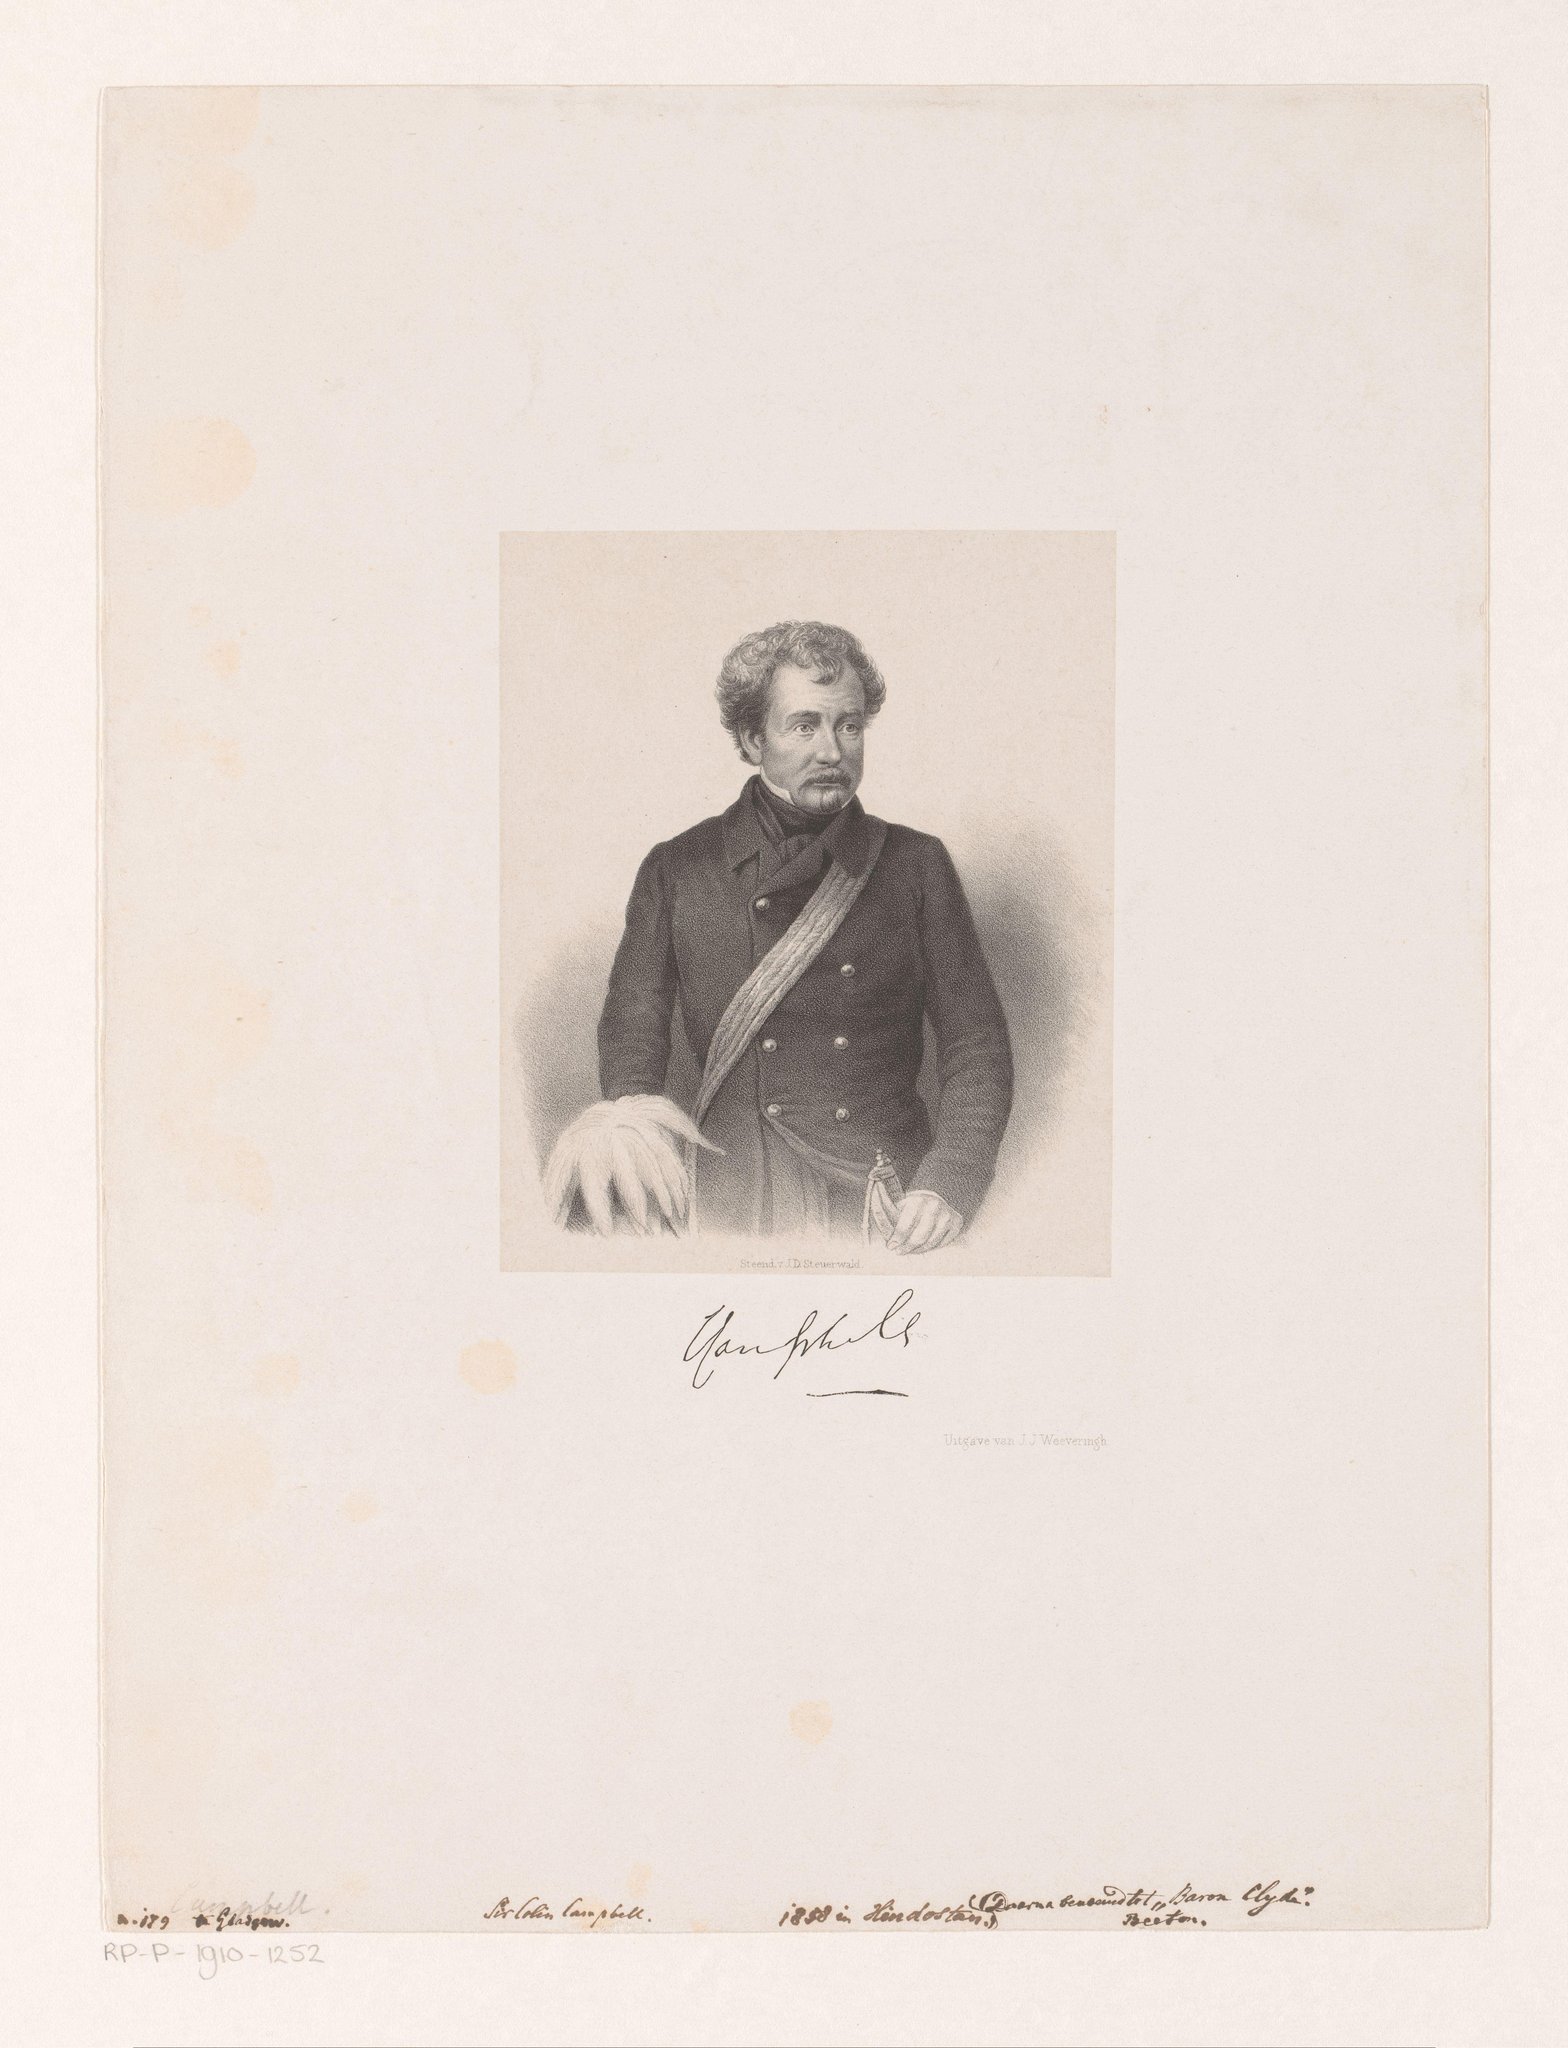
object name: print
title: Portret van Colin Campbell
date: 1822-1863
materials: paper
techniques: lithograph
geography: haarlem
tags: historical persons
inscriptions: collector's mark: Lugt 2228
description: Onder het portret de signatuur van de geportretteerde.